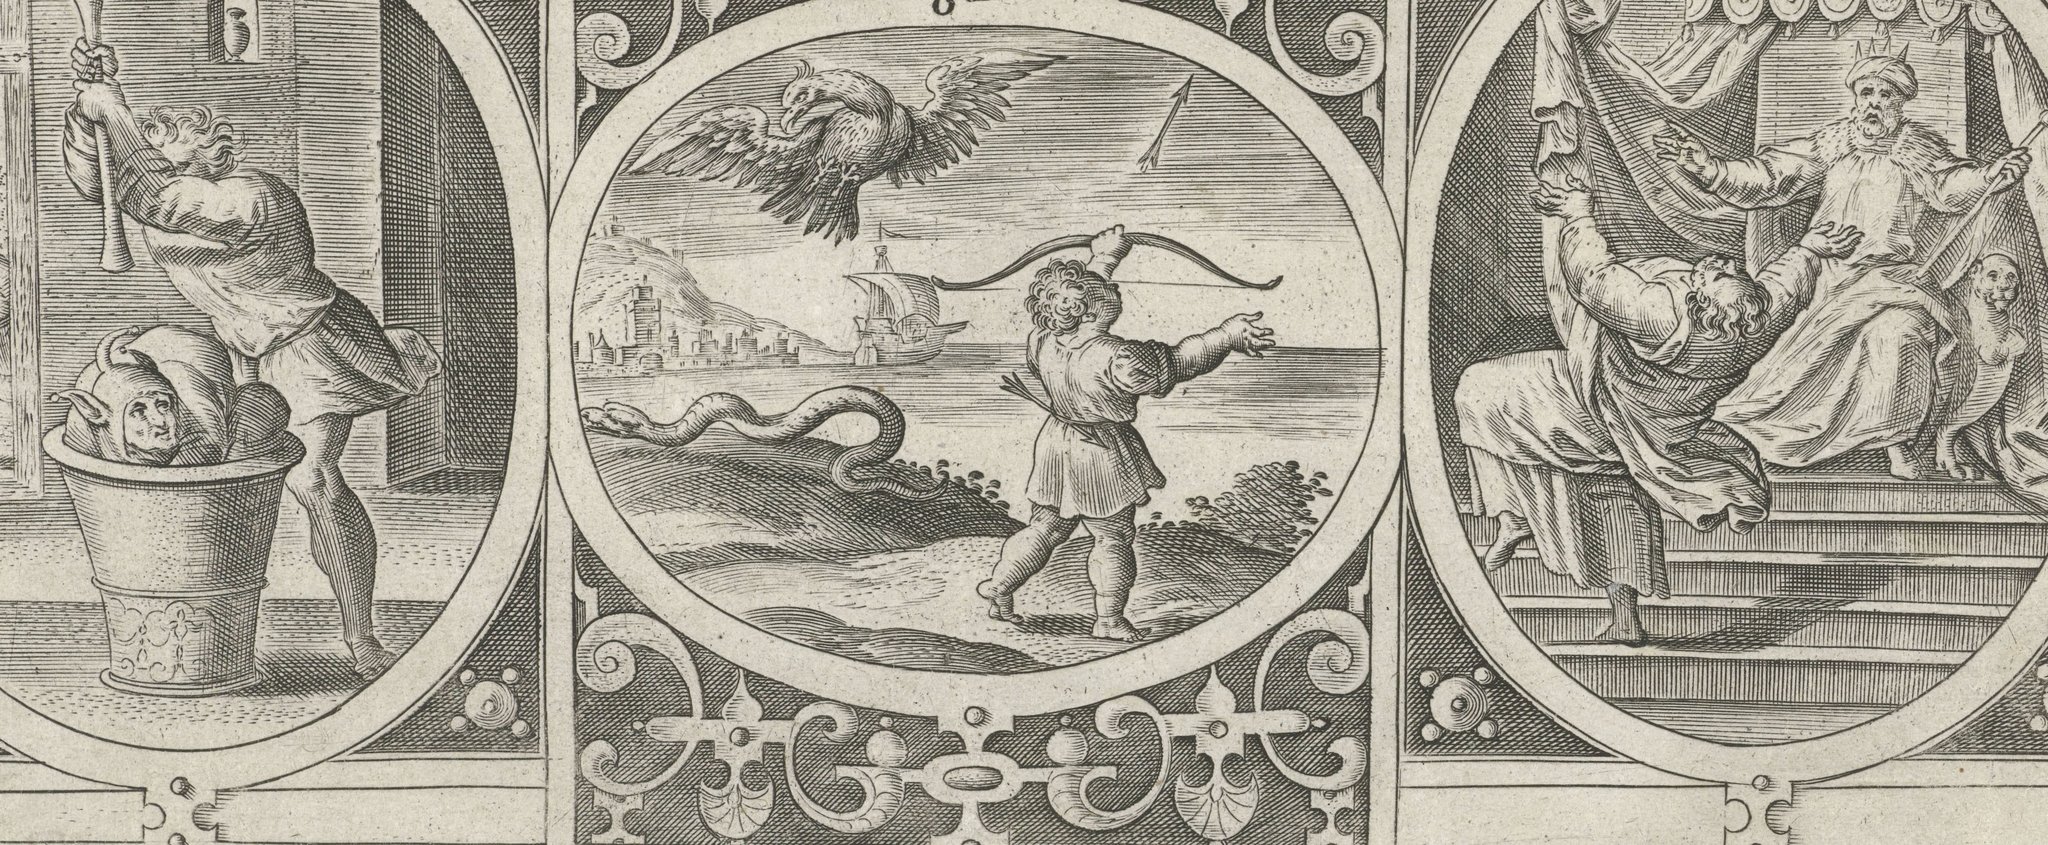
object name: print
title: Spreuken van Salomo, onder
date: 1547-1591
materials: paper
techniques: engraving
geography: antwerp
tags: the book of proverbs (with book chapter:verse)